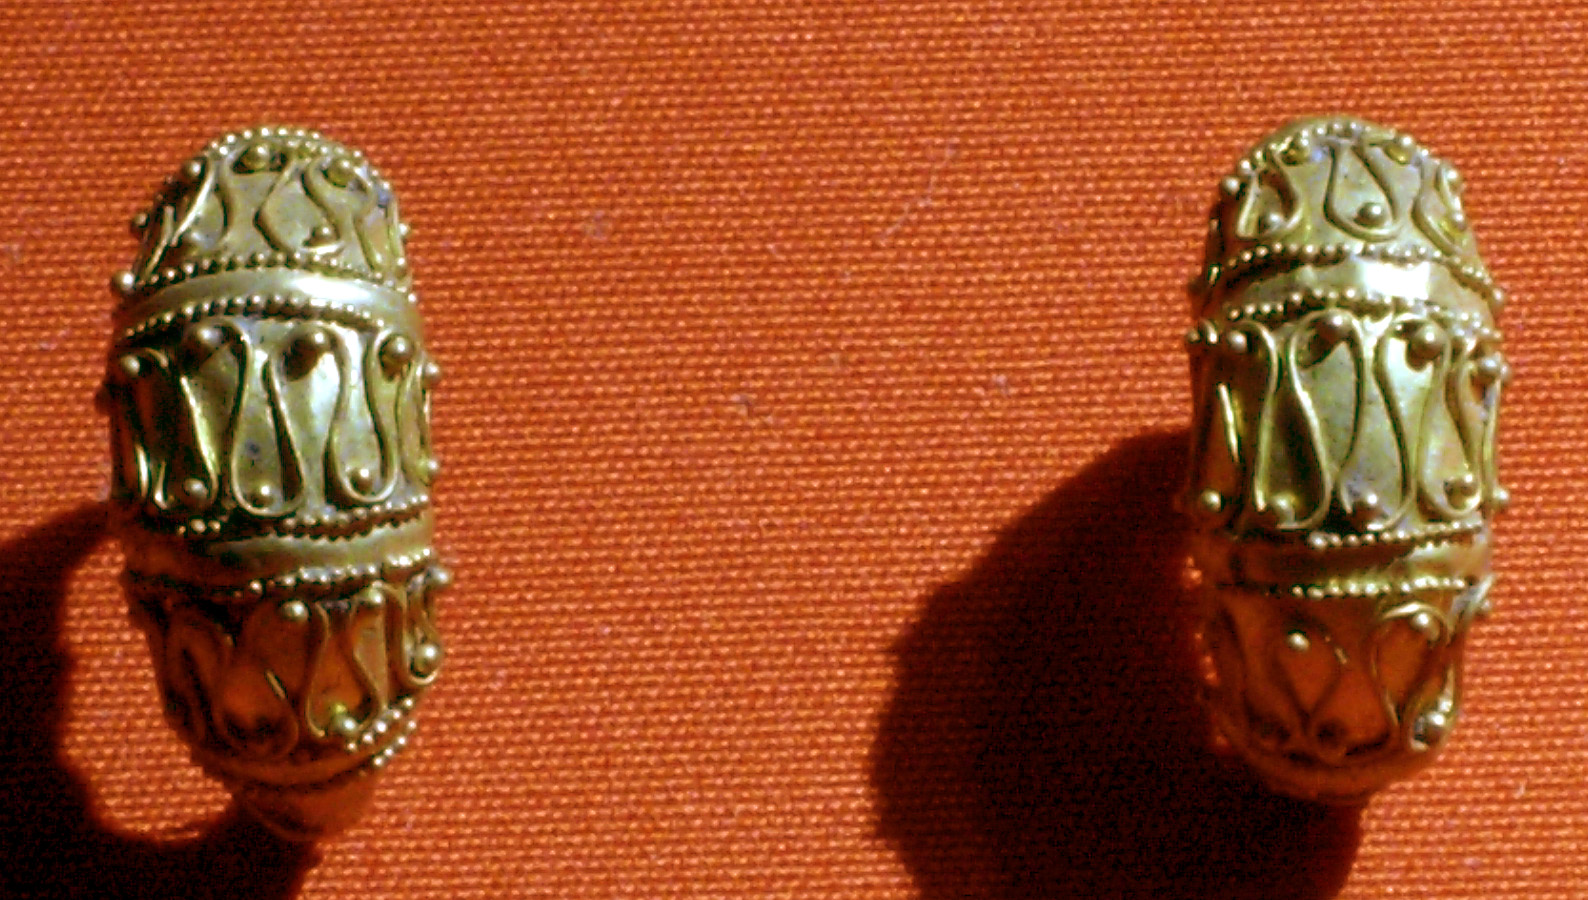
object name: earring, boat shaped, filagree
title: Pair of boat-shaped earrings with filigree and granule decoration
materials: gold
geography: egypt